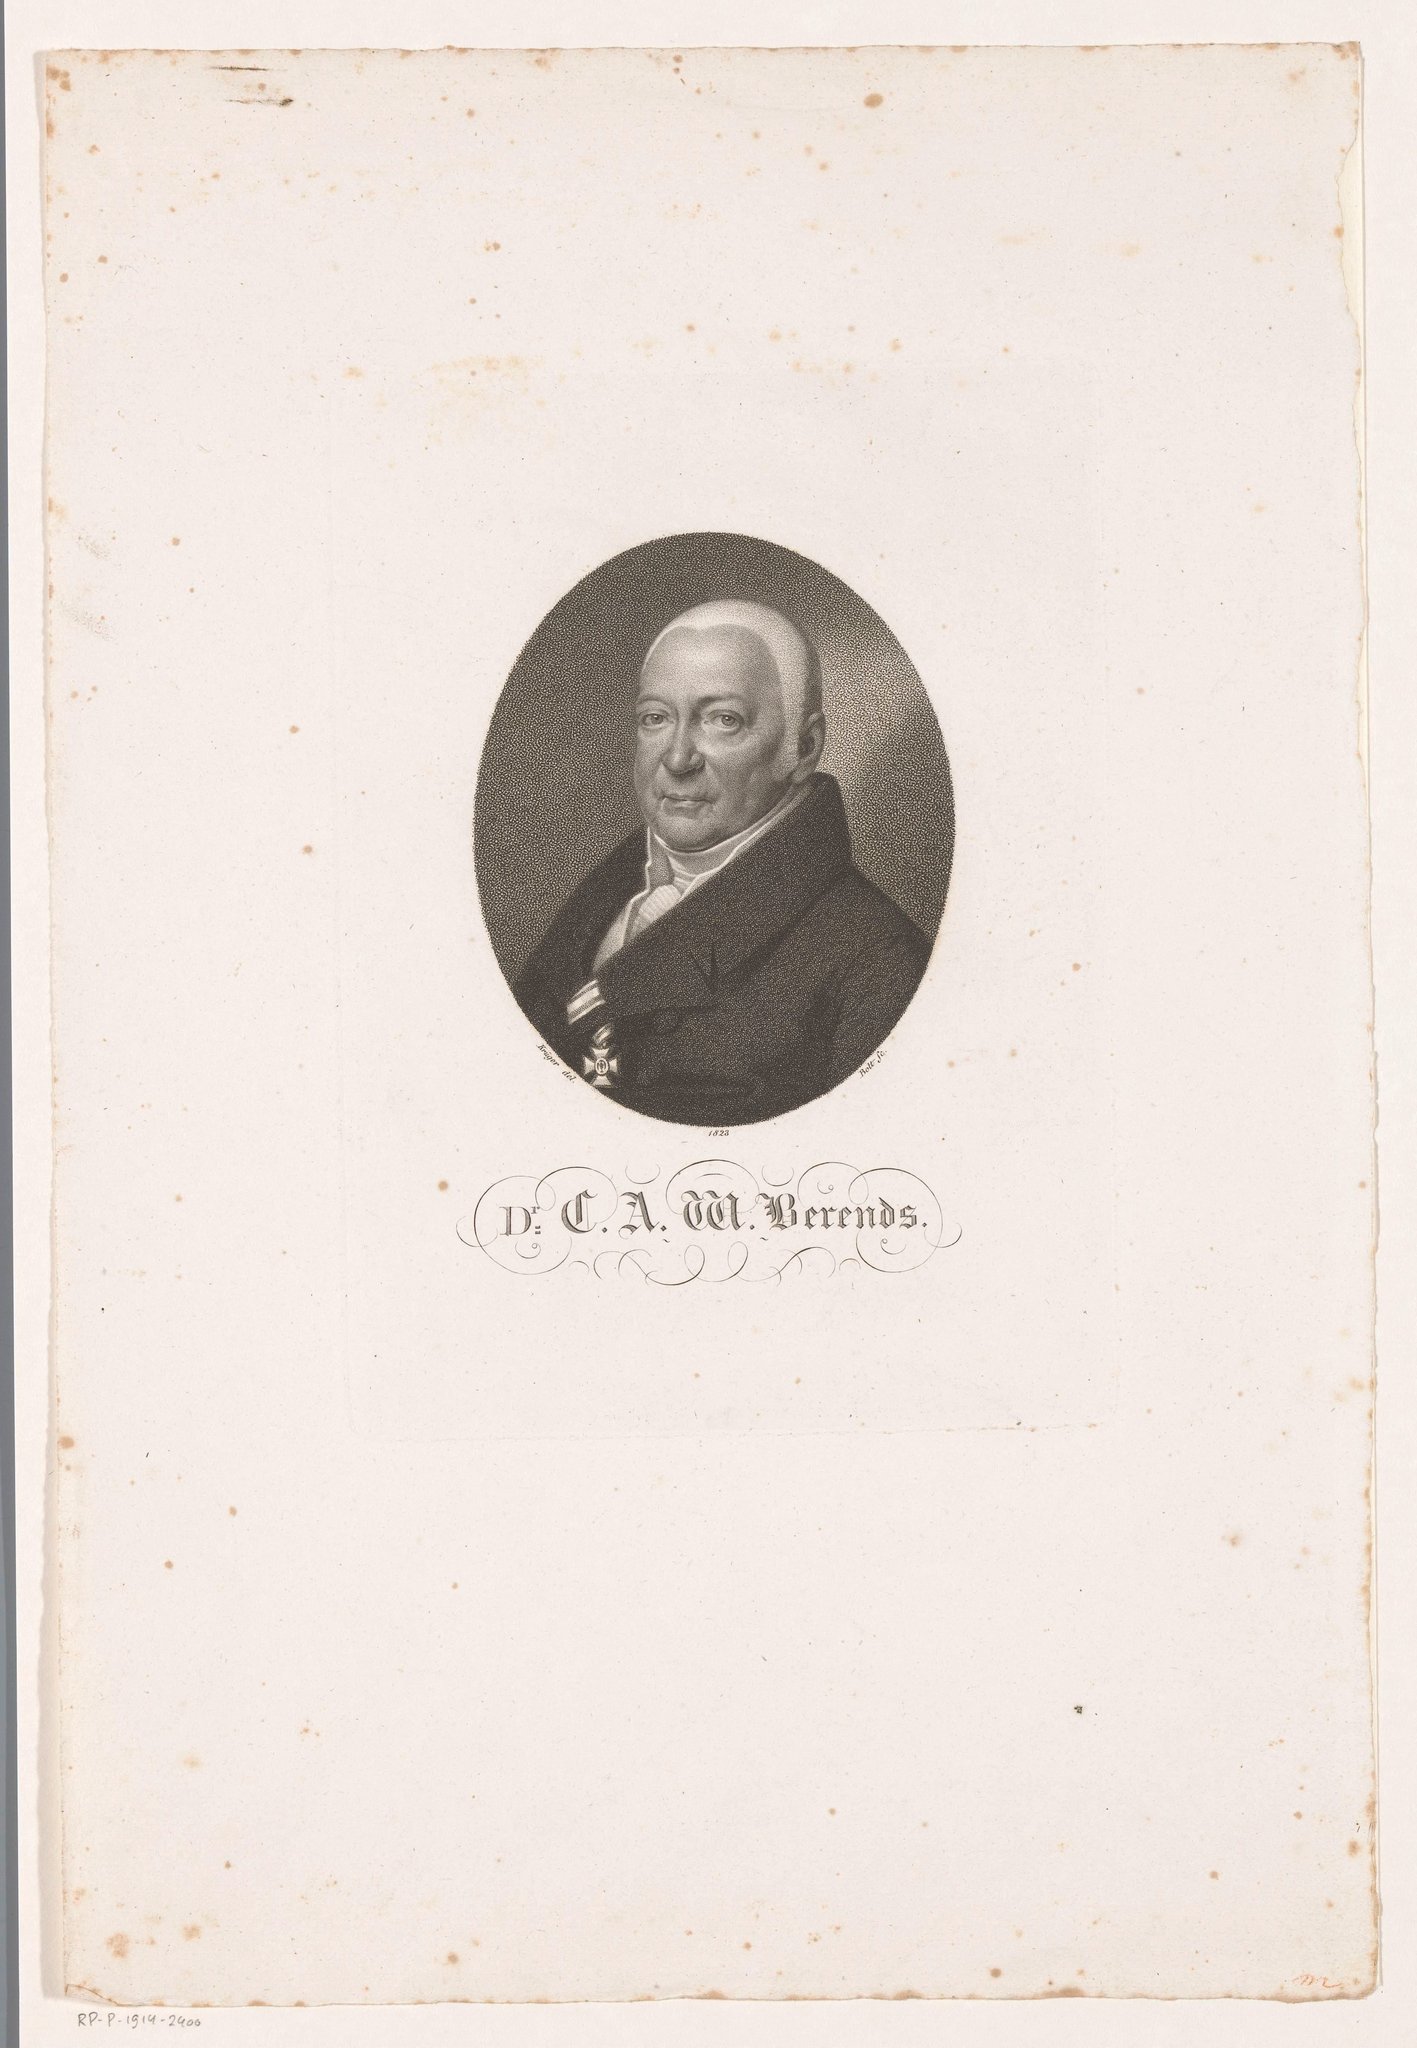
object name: print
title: Portret van Karl August Wilhelm Berends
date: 1823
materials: paper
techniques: stippling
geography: berlin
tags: historical persons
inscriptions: collector's mark: Lugt 2228